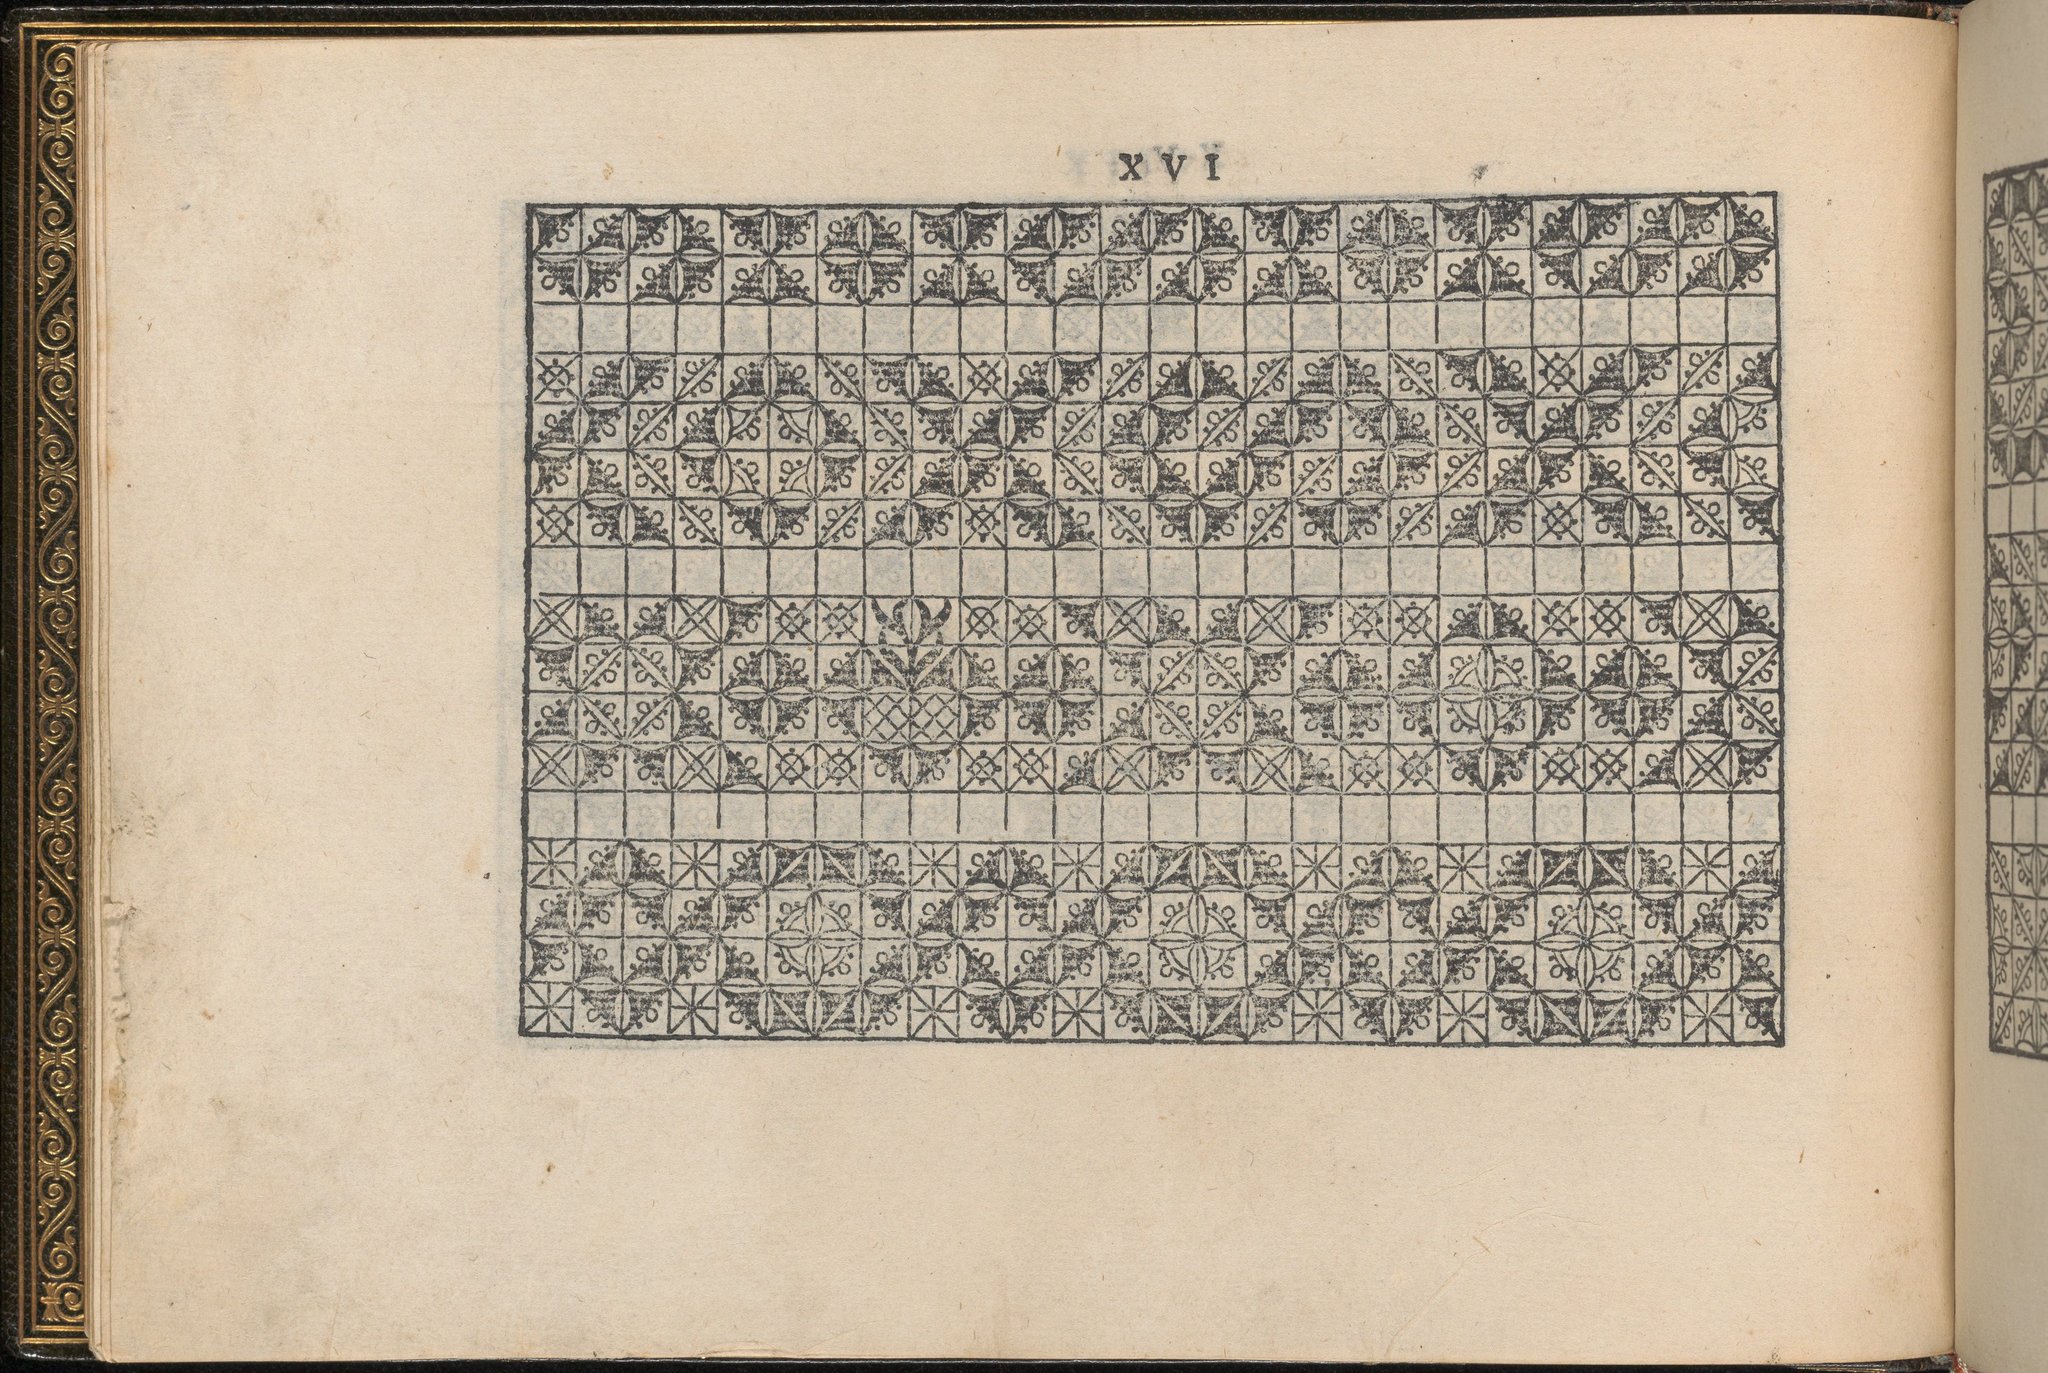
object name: book print ornament architecture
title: La Vera Perfettione del Disegno di varie sorti di recami, page 8 (verso)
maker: giovanni ostaus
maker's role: publisher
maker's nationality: italian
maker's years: 1507-1607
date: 1567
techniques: woodcut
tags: ornament